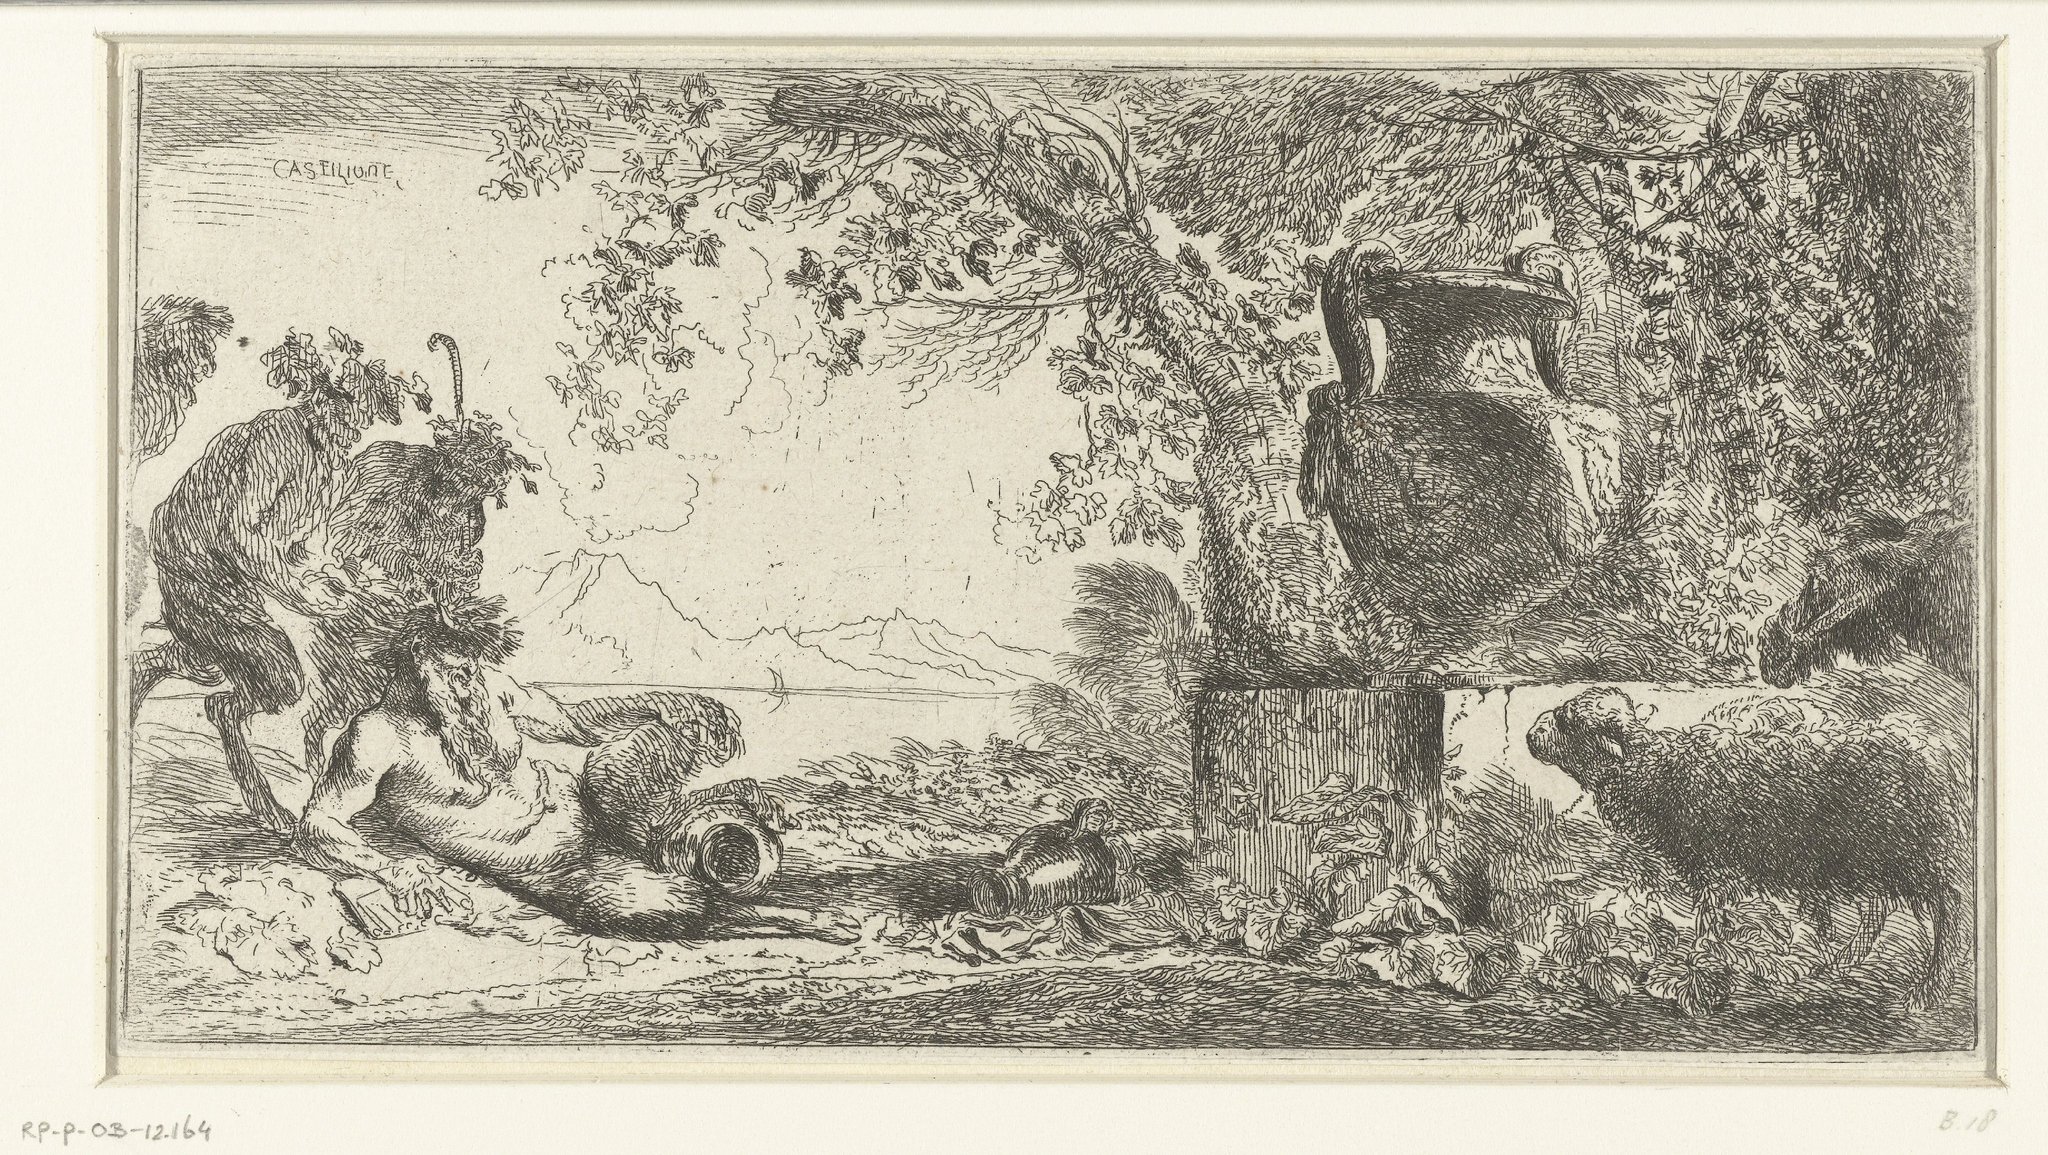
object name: print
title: Pan liggend bij een grote vaas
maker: giovanni benedetto castiglione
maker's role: draughtsman, print maker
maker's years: 1610-1665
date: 1643-1647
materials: paper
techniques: etching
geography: rome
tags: panpipes, (story of) pan, garden vase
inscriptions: collector's mark: Lugt 240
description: Pan liggend bij een grote vaas, in zijn rechterhand de syrinx (panfluit). Achter hem drie saters.